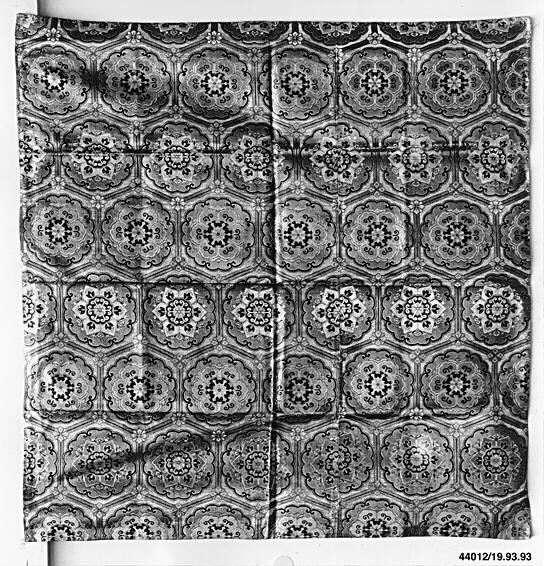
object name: altar cloth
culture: japanese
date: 1615-1868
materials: metal thread, silk